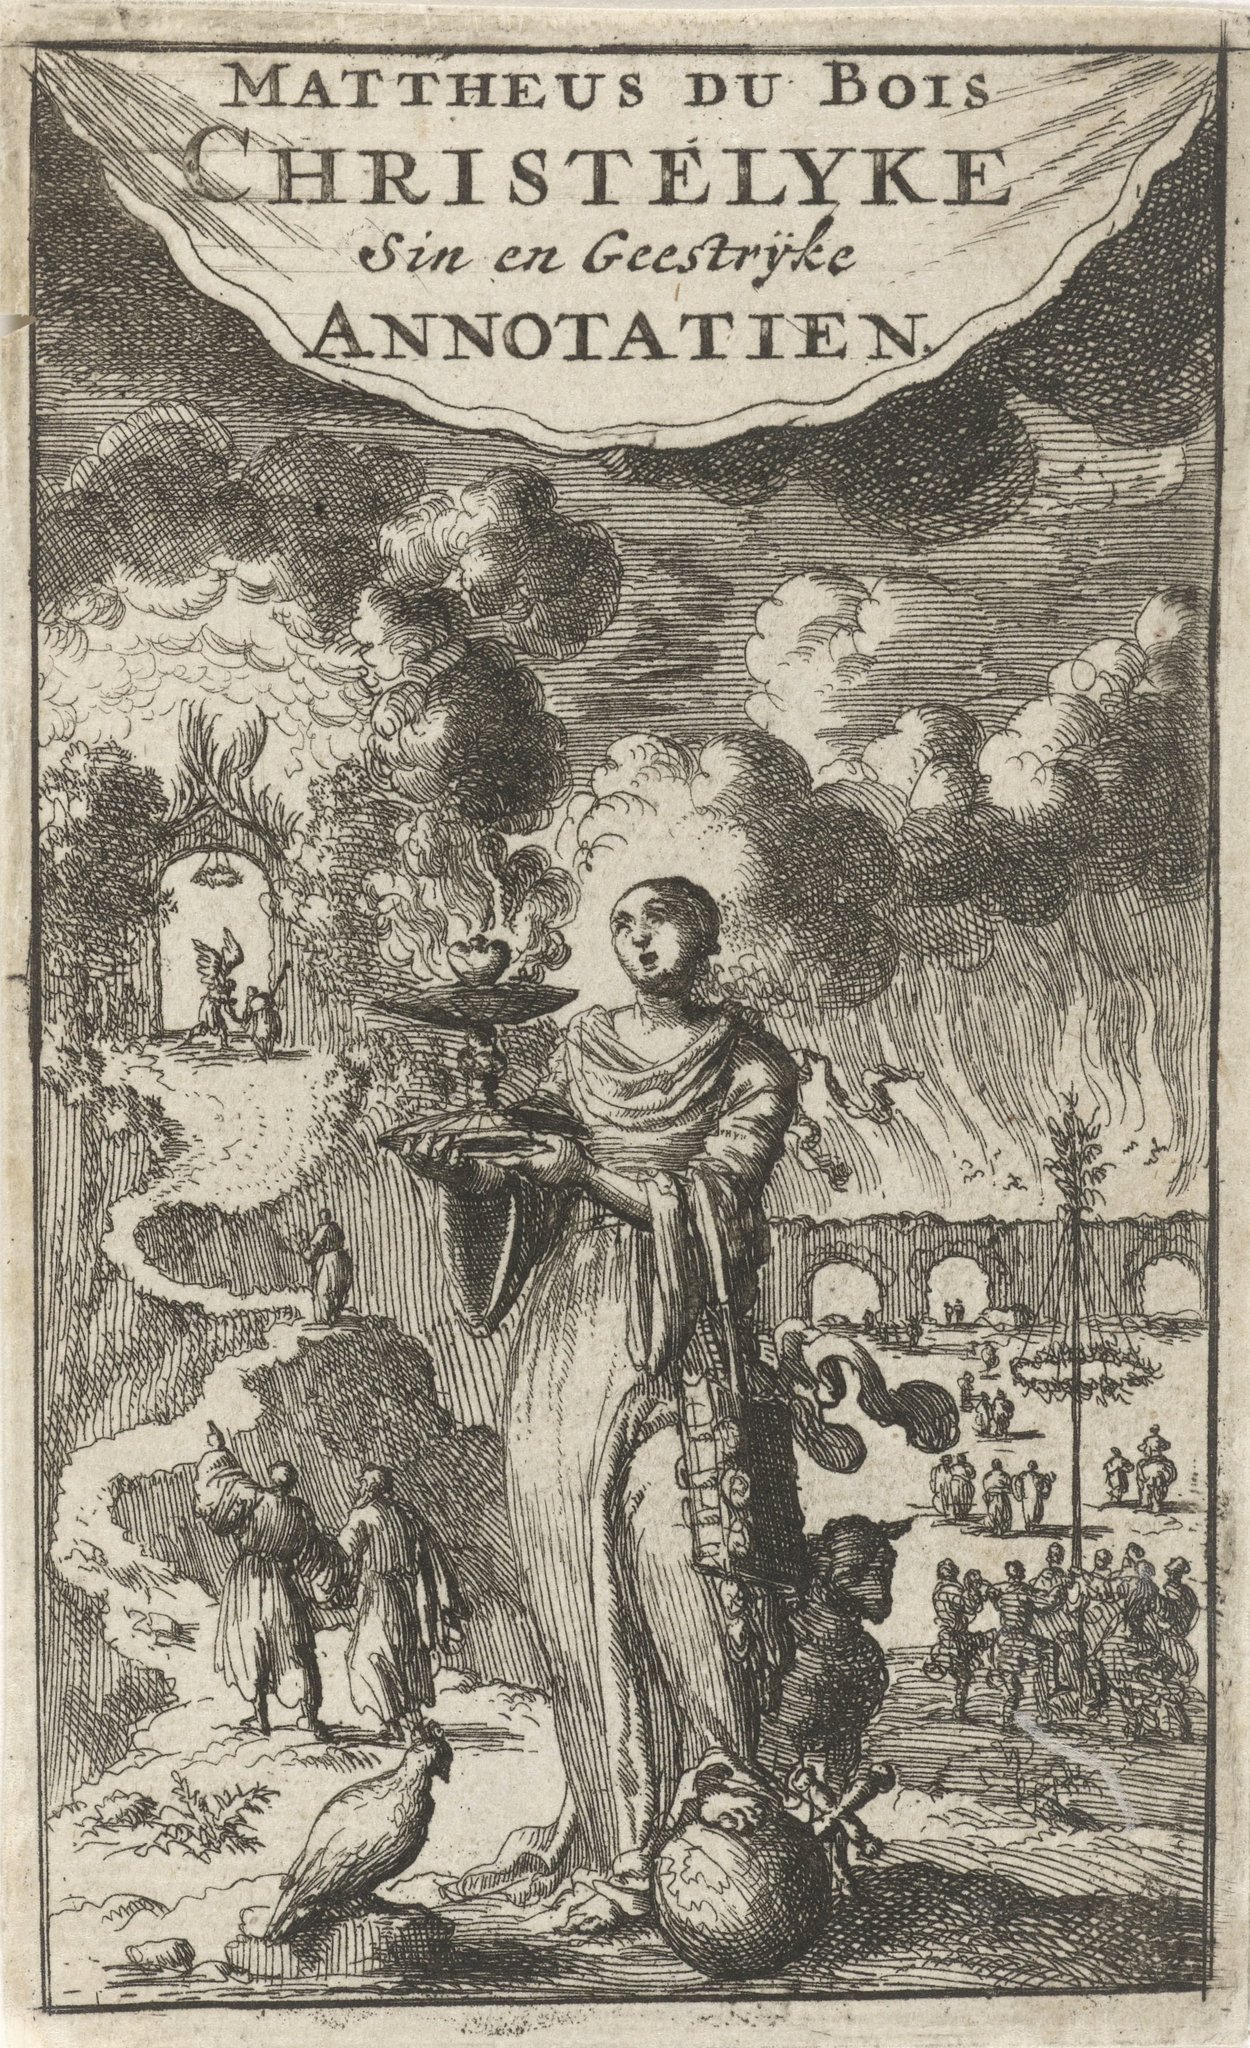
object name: titelblad, titelpagina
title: Vrouw draagt een brandend hart op een schaal terwijl ze met haar voet op een rijksappel steunt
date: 1686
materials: paper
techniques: etching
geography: amsterdam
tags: the sacred heart, orb (symbol of sovereignty; sphere with cross on top) - bb - female ruler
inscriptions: collector's mark: Lugt 2228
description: Titelpagina voor: Bois, Mattheus. Christelyke Sin- en Geestryke Annotatien, Zijnde een versameling van vele Christelijcke Ondervindingen. Amsterdam: Jacob van den Velde, 1686.